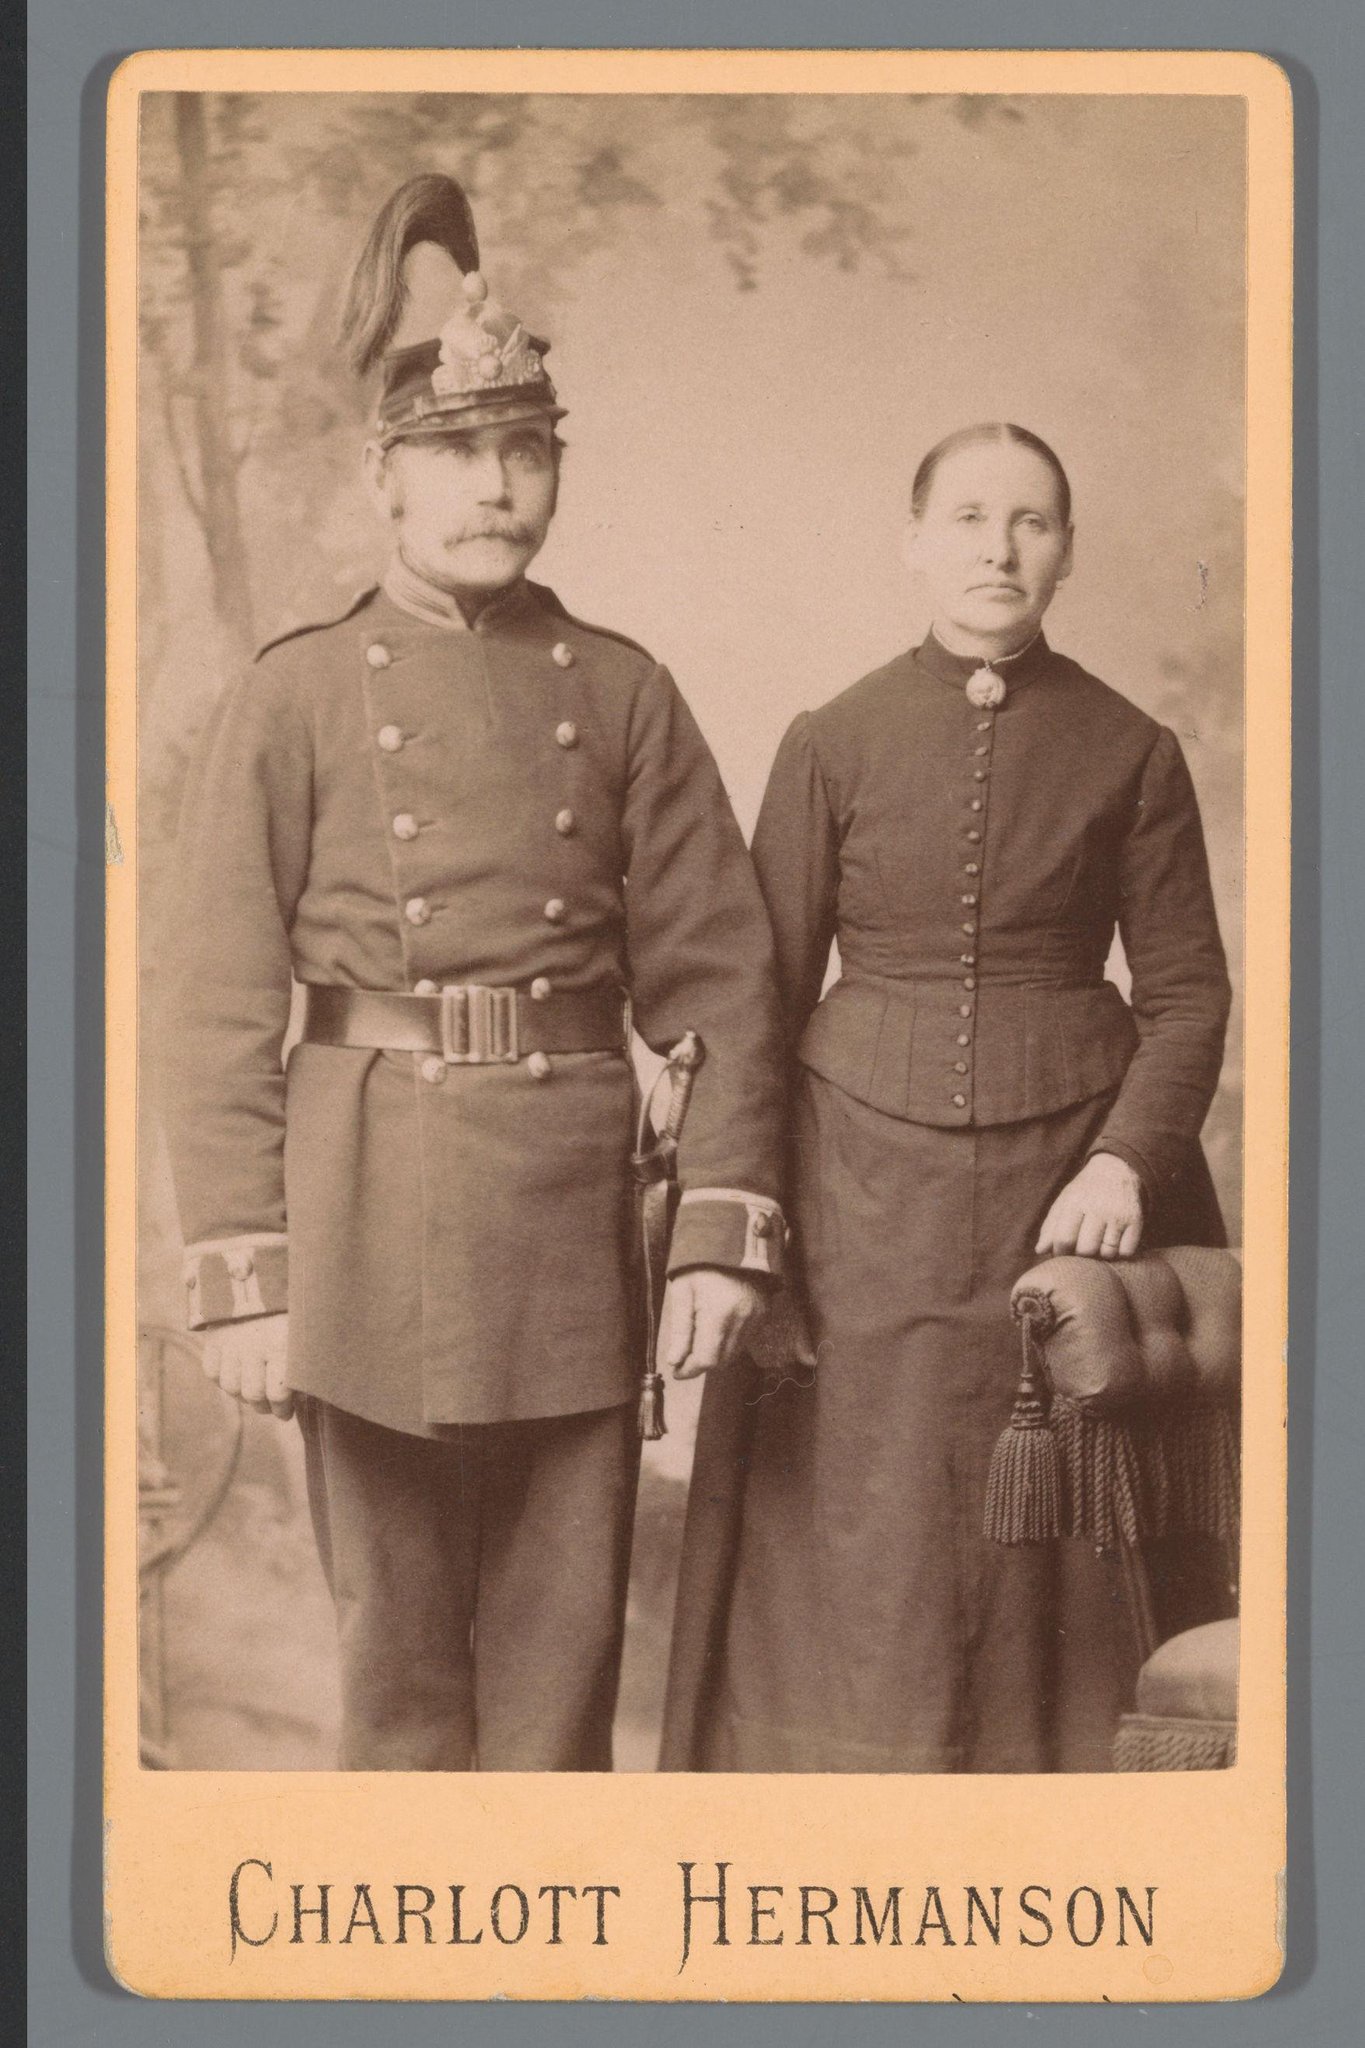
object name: carte de visite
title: Portret van een onbekende man en vrouw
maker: charlotta fredrika hermansson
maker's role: fotograaf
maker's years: 1852-1921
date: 1890-1903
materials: cardboard, paper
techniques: albumen print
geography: skara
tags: adult woman, adult man, anonymous historical person portrayed, (military) uniforms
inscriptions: address: ‘Skara/ Torggatan 47.’, inscription: ‘Plåten förvaras./ N. P.’